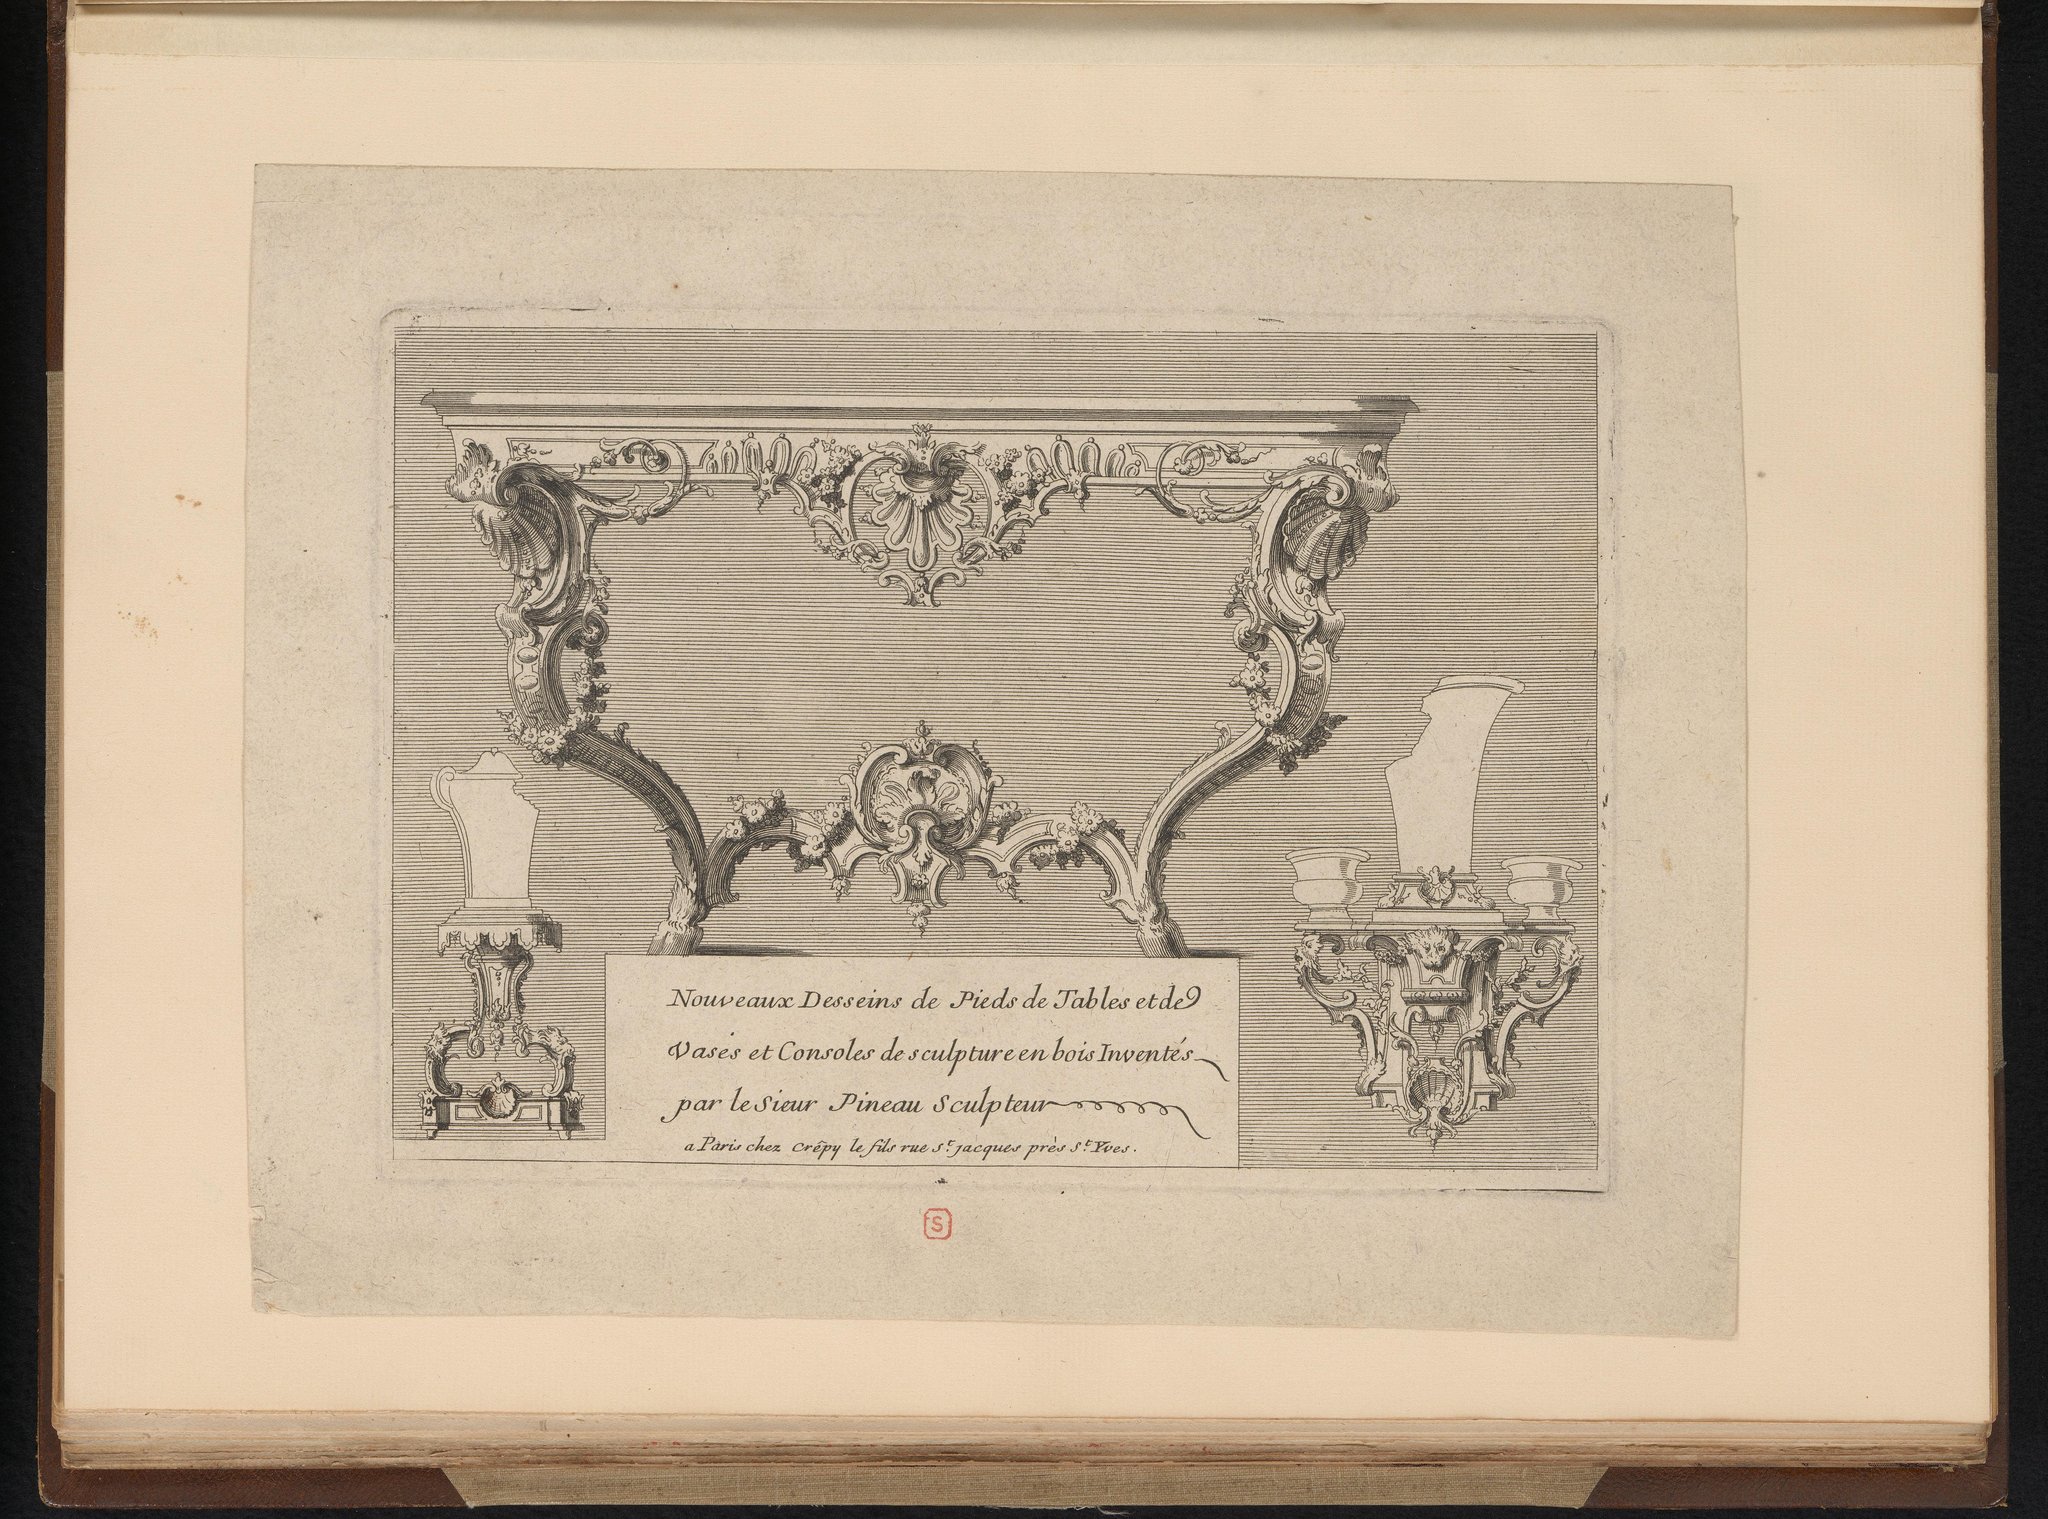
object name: album leaf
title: Nieuwe ontwerpen van tafelpoten en consoles in hout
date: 1725-1750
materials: paper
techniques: etching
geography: paris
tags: ornaments ~ art, sconce, wall lamp, table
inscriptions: collector's mark: Lugt 2342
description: Twee ontwerpen voor consoles waarop vazen geplaatst kunnen worden, en een ontwerp voor tafelpoten. Deze prent maakt deel uit van een album.